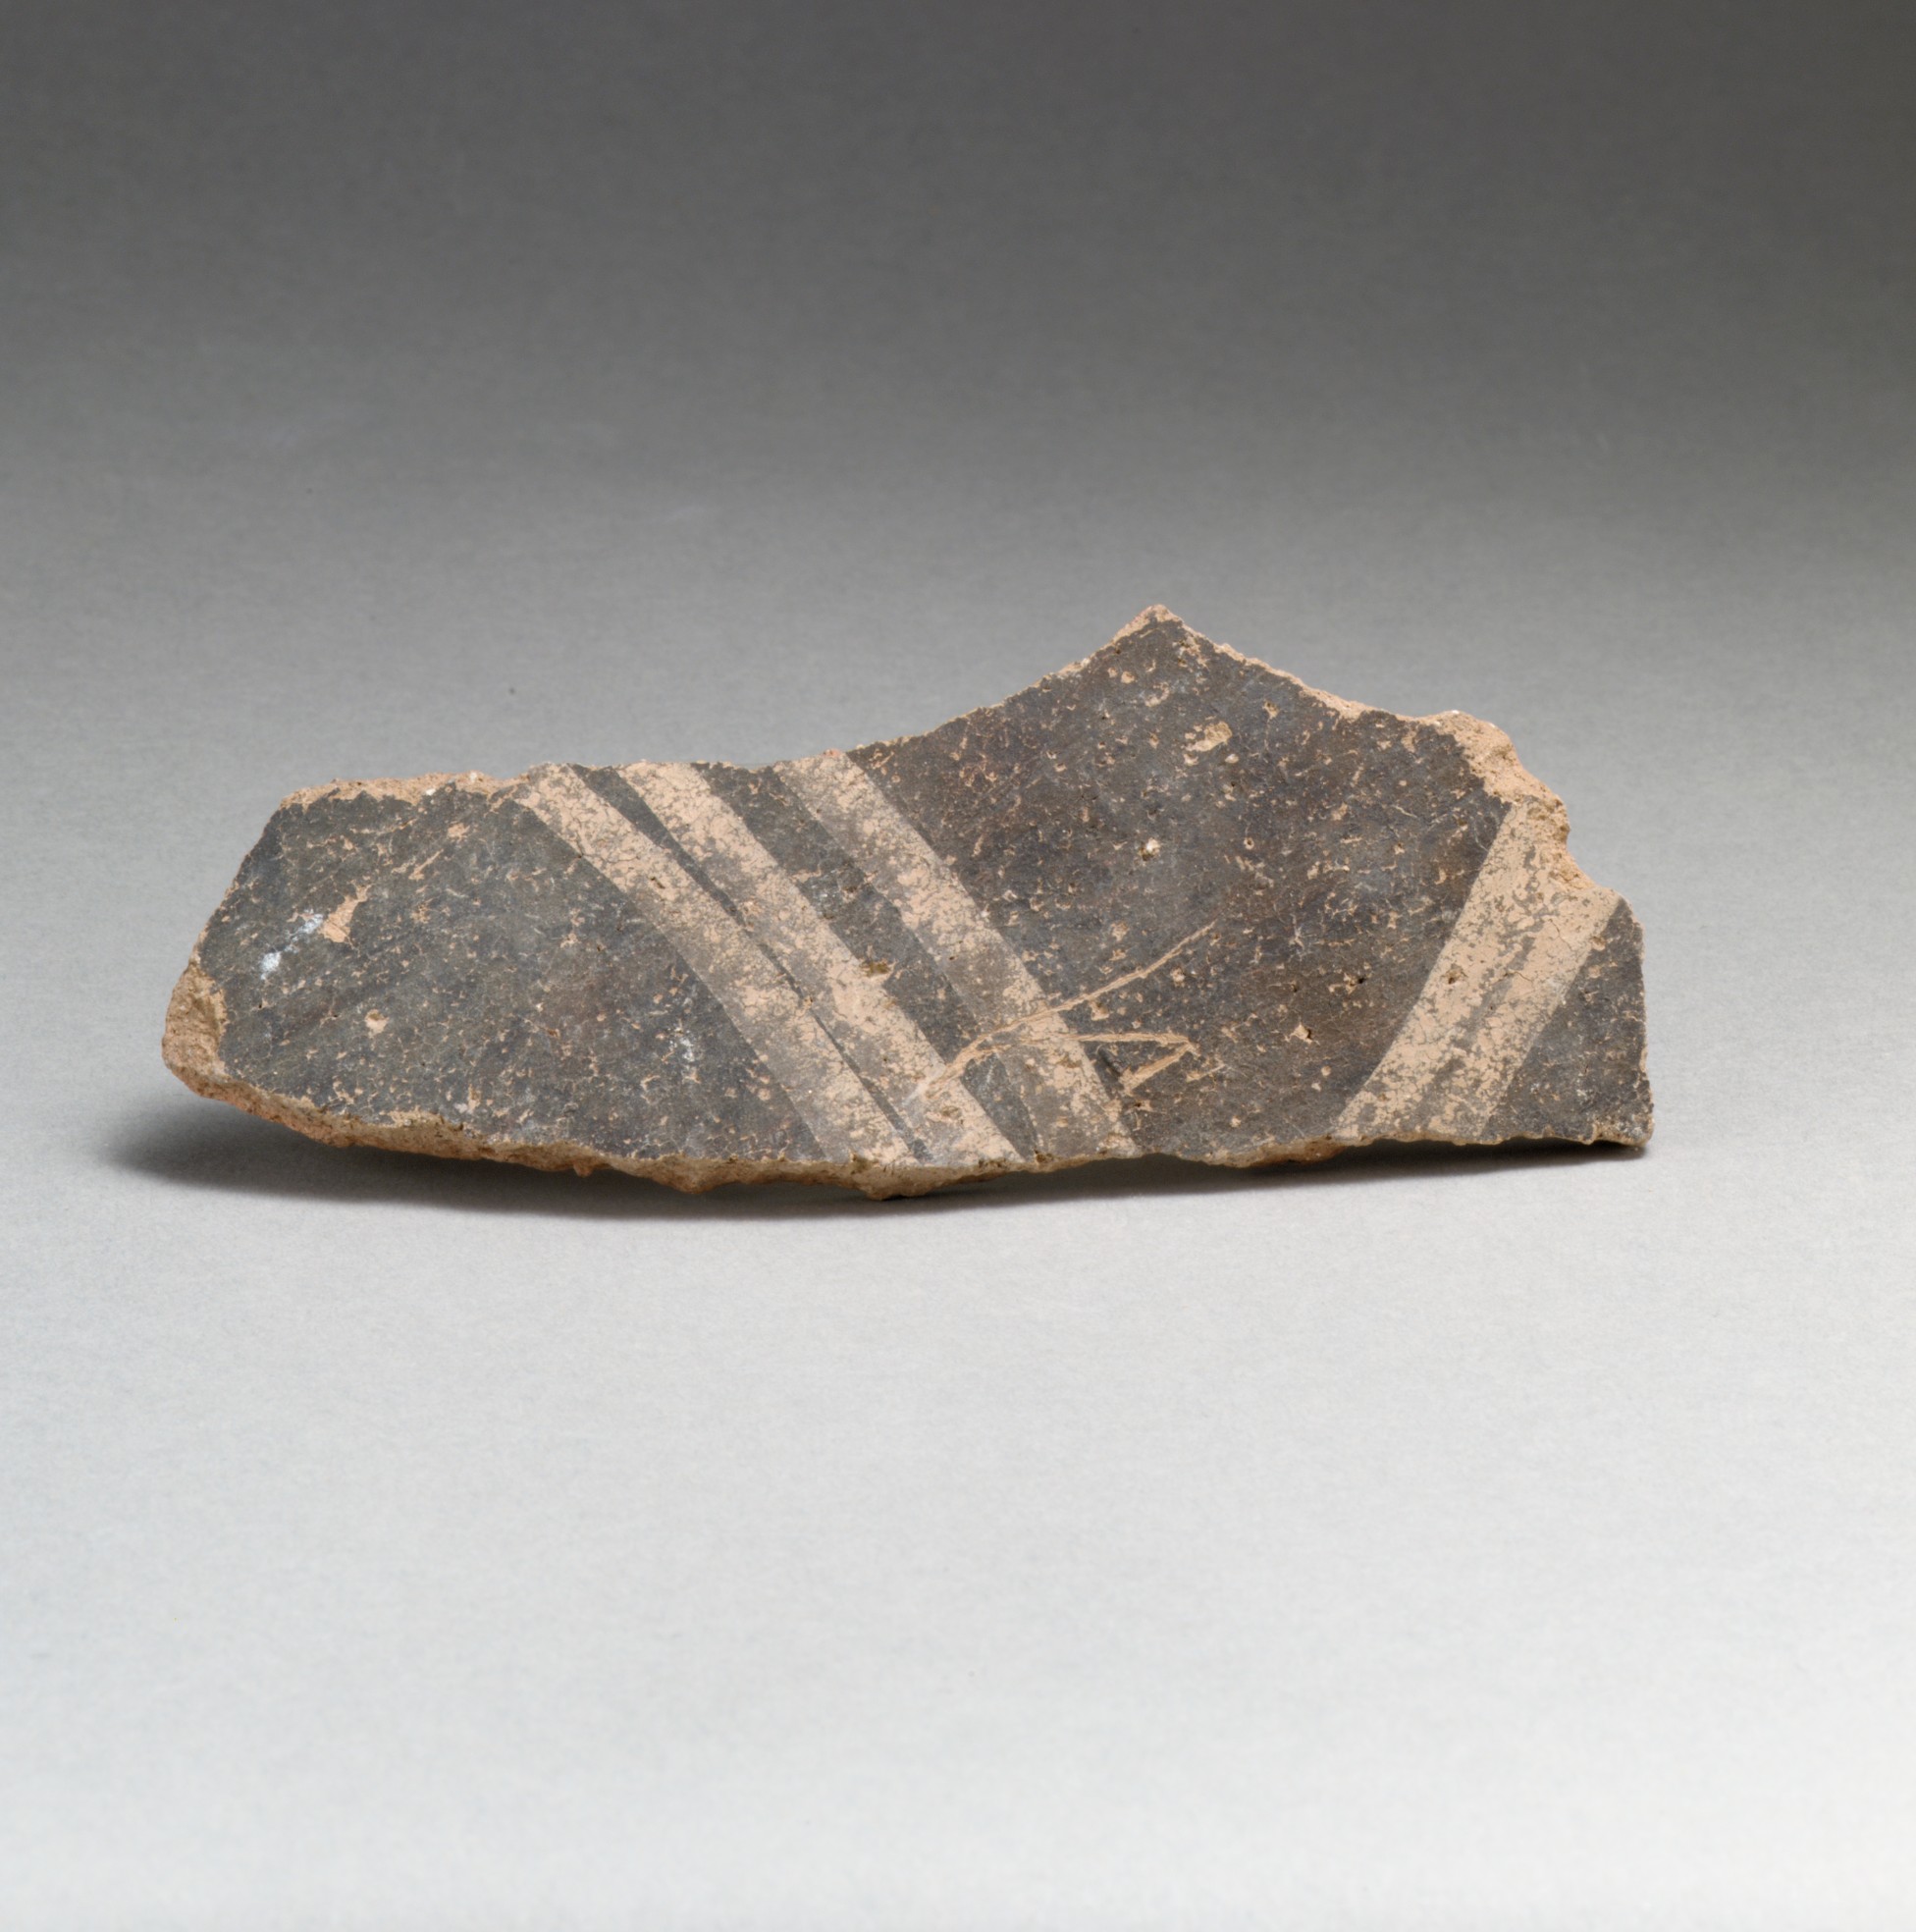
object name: vase fragment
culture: minoan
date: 2600-2000 BCE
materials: terracotta